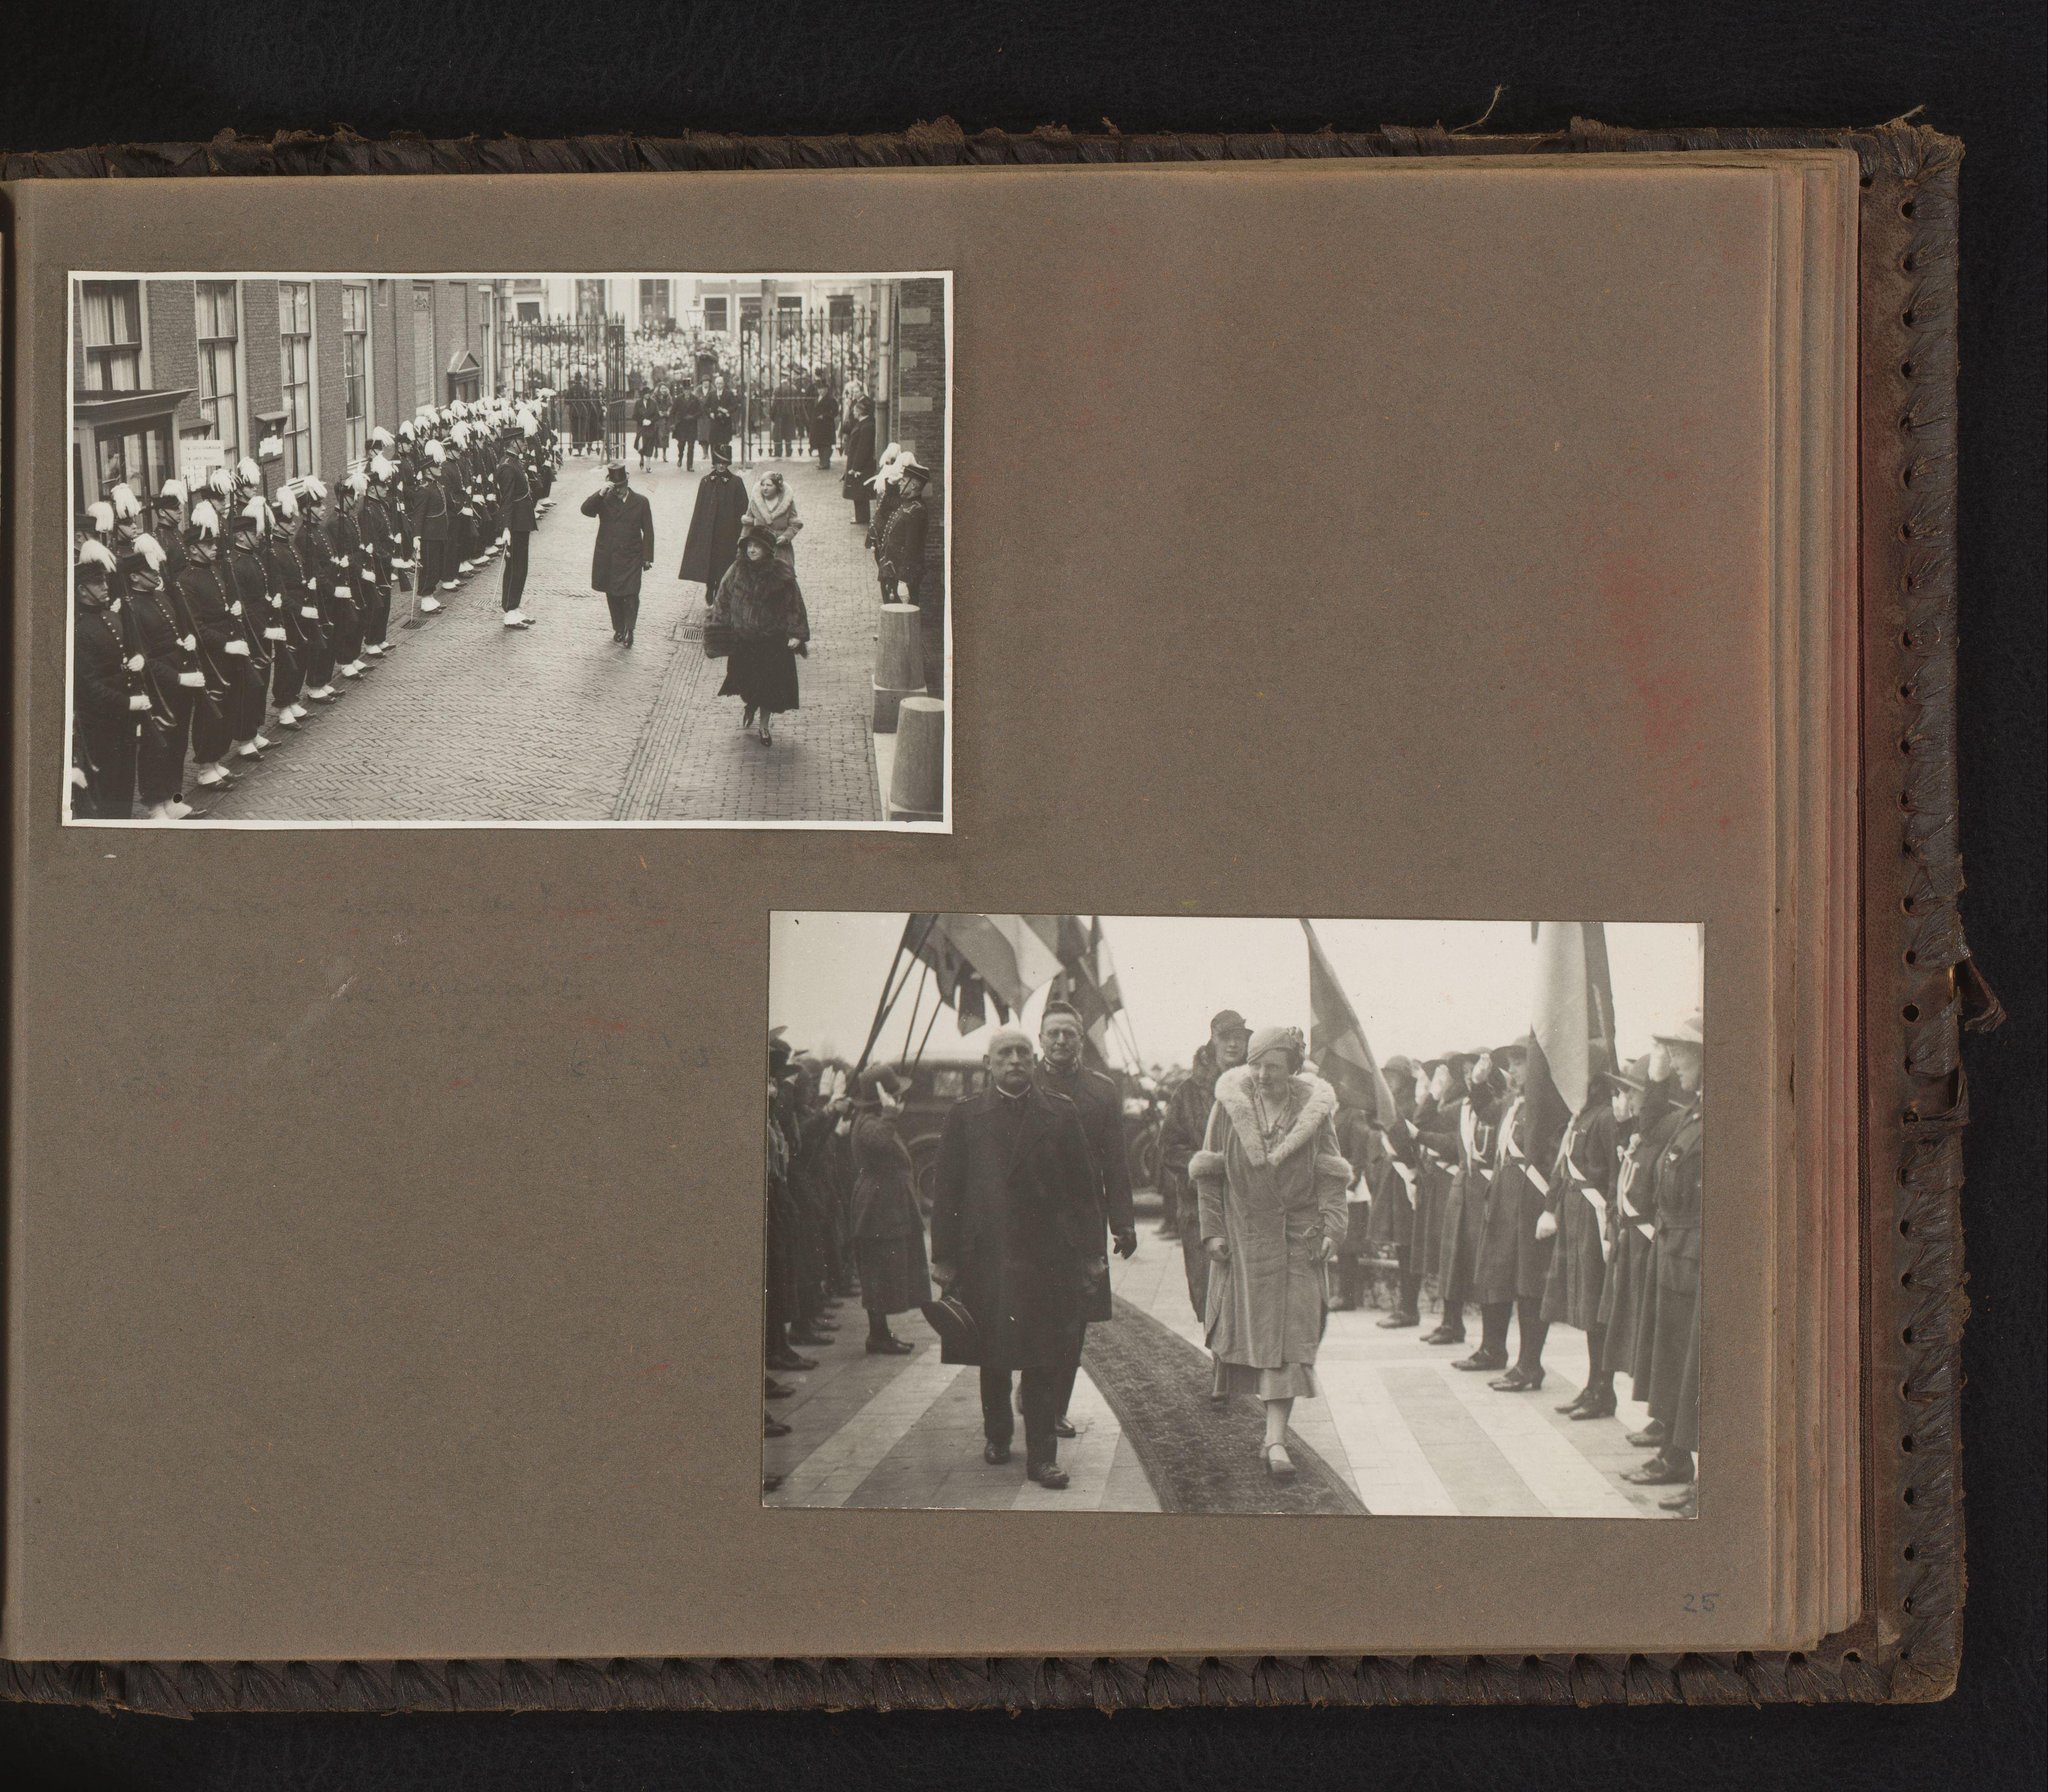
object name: photograph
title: Twee foto's van prinses Juliana, op bezoek in Leiden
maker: Anonymous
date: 1930-1936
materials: paper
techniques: gelatin silver print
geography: leiden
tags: the hague, juliana of the netherlands, princess, leiden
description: Deze foto's maken deel uit van een album.